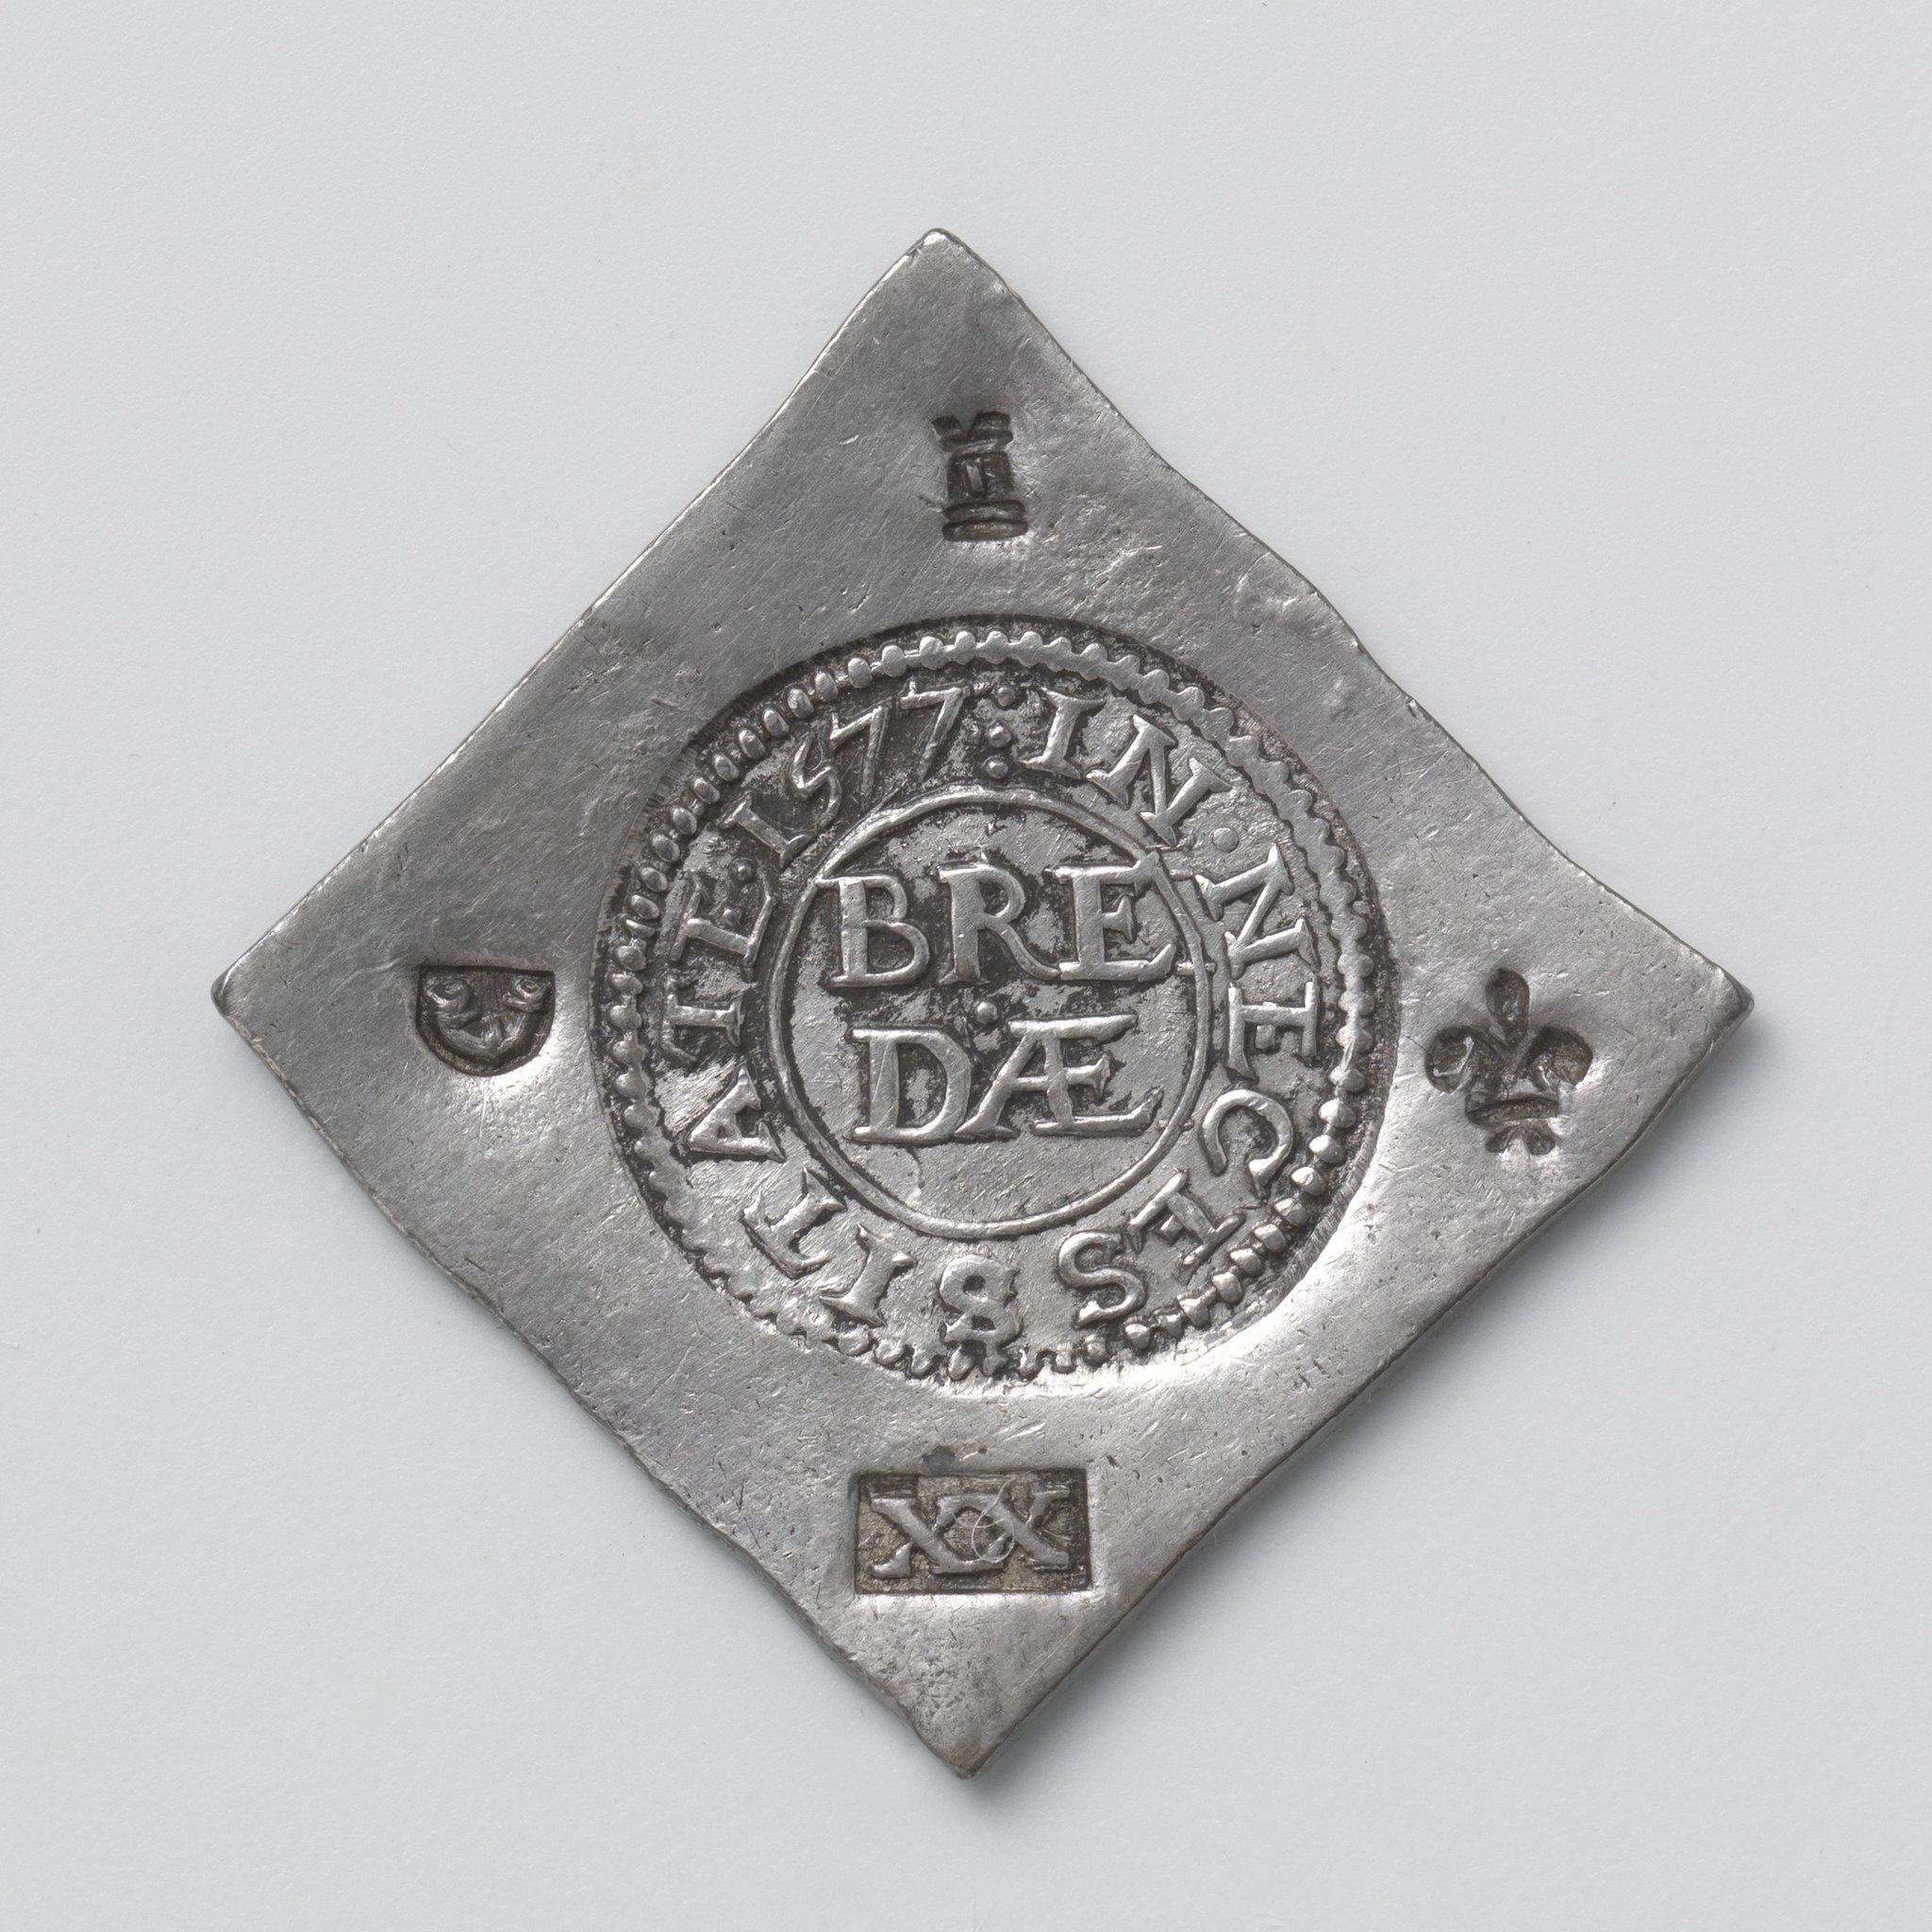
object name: siege coin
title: Twelve emergency coins from Dutch cities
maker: Anonymous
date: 1509-1577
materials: silver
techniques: striking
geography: netherlands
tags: breda, tachtigjarige oorlog, inname van breda (1577)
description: The cities besieged by the Spanish army for having revolted against Spanish rule in the 1570s experienced severe shortages of virtually everything, including money to pay the soldiers. Emergency money was therefore minted. Gold, silver, paper: anything in the cities under siege could be used as temporary currency.